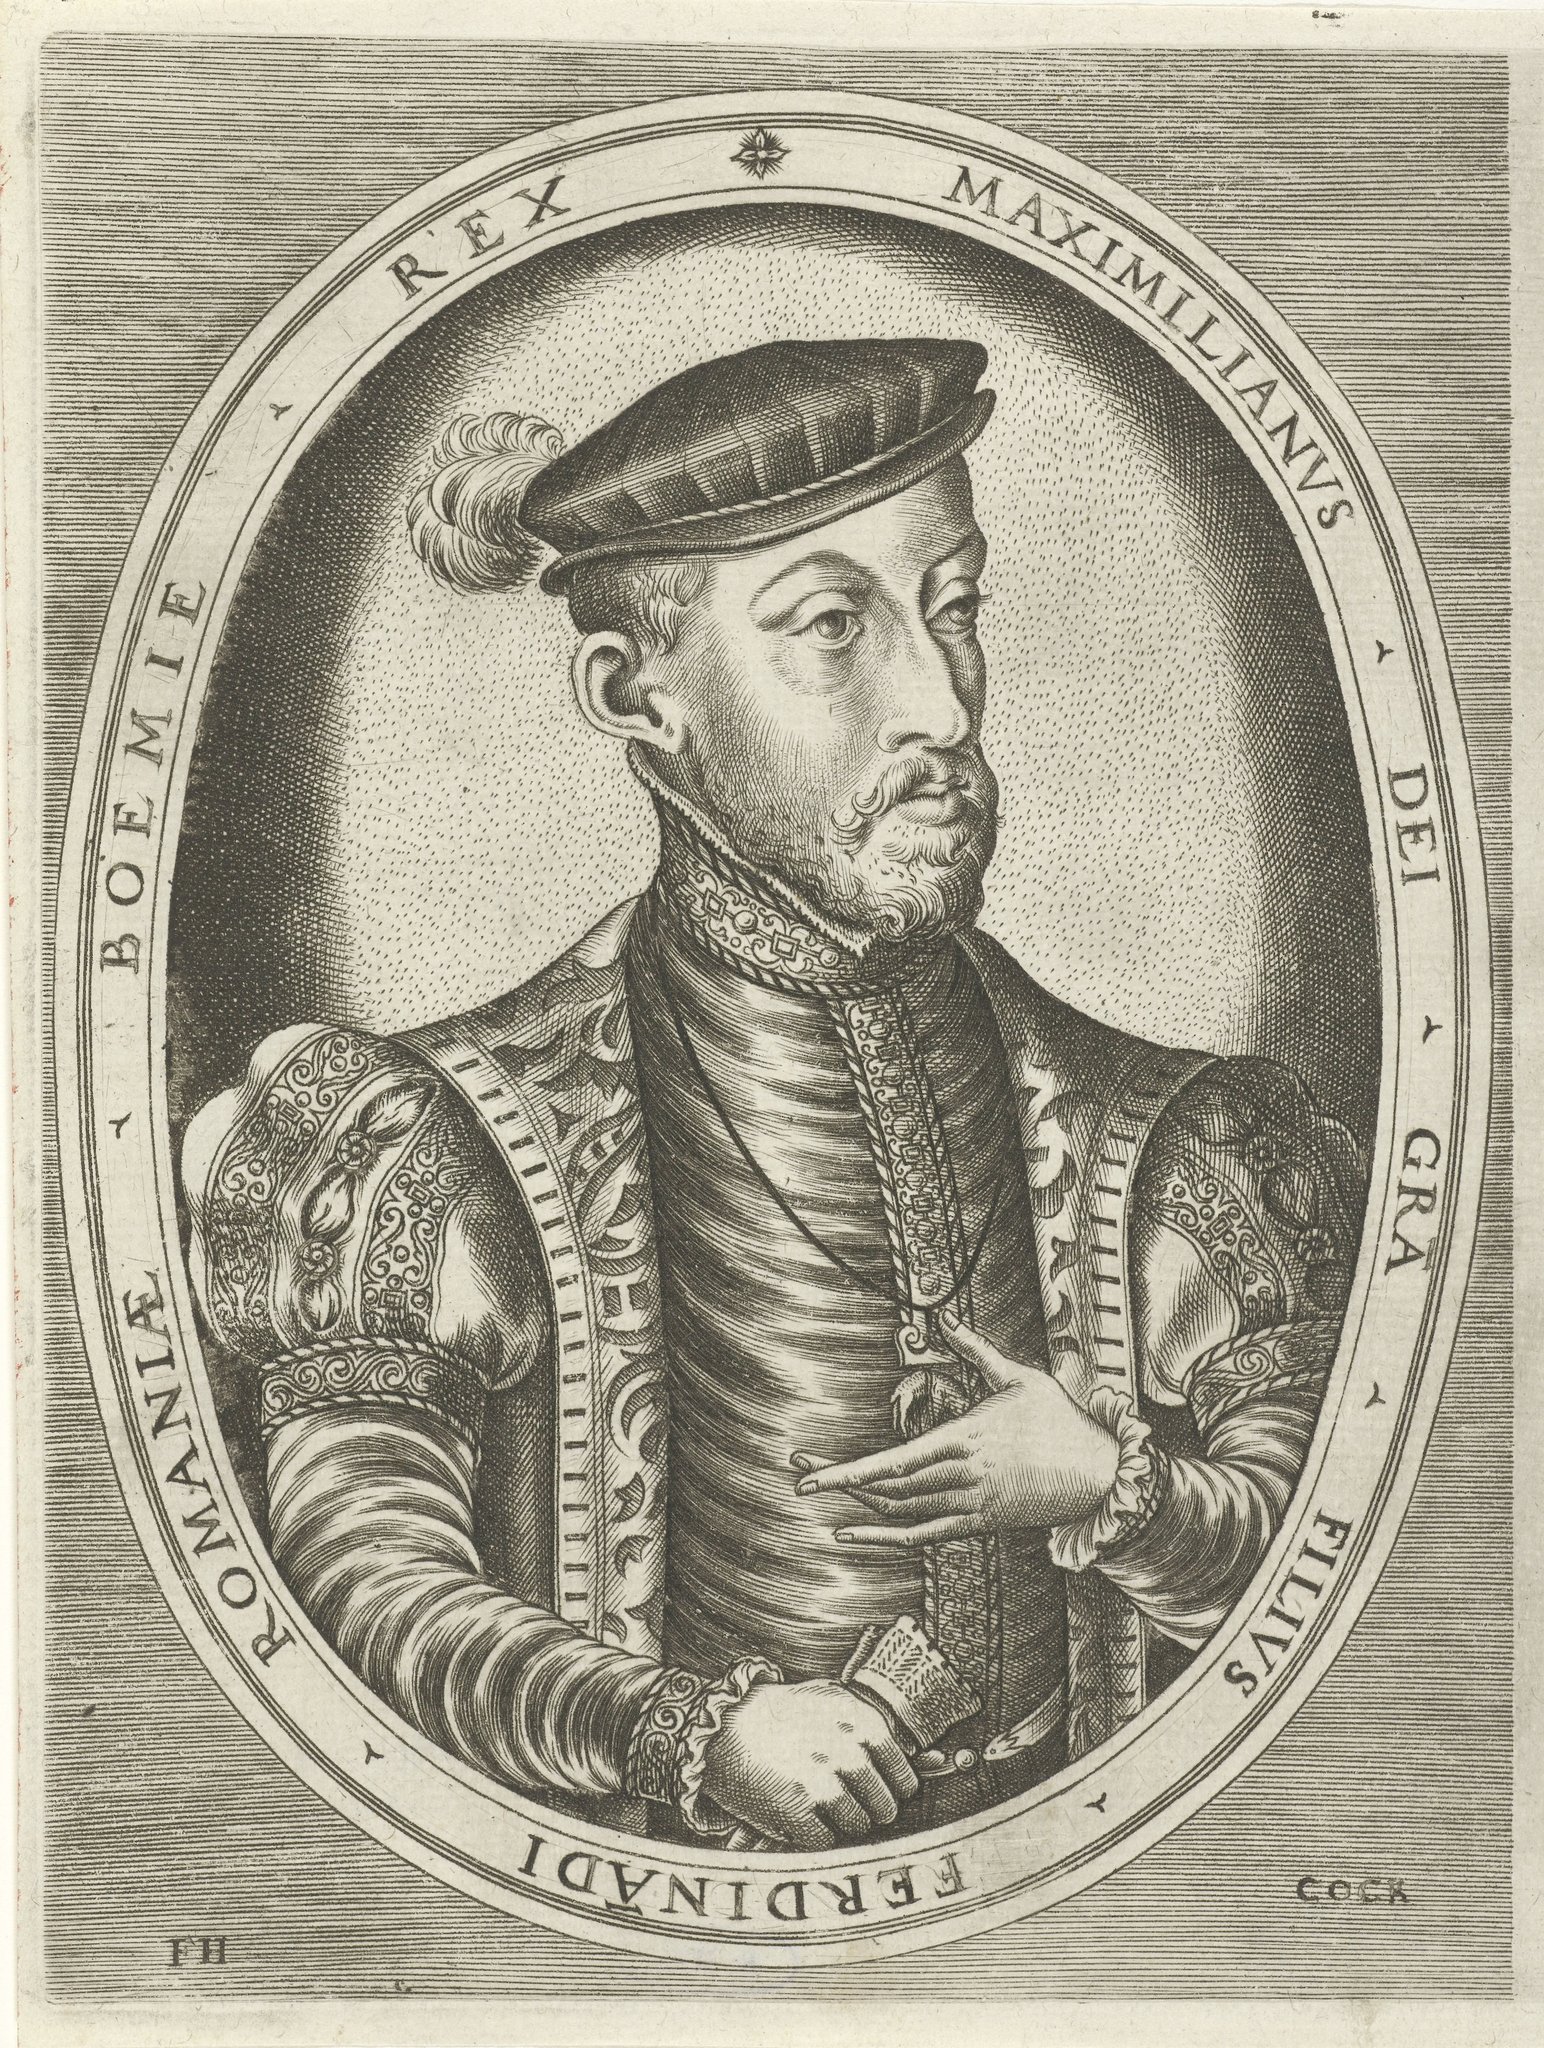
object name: print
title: Portret van keizer Maximiliaan II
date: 1546-1562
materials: paper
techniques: engraving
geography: antwerp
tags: vienna, maximiliaan ii (keizer van heilige roomse rijk)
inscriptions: collector's mark: Lugt 2228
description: Portret van Maximiliaan II, Duits keizer, ten halven lijve naar rechts met een paar handschoenen in zijn rechterhand, in een ovale lijst met randschrift in het Latijn.